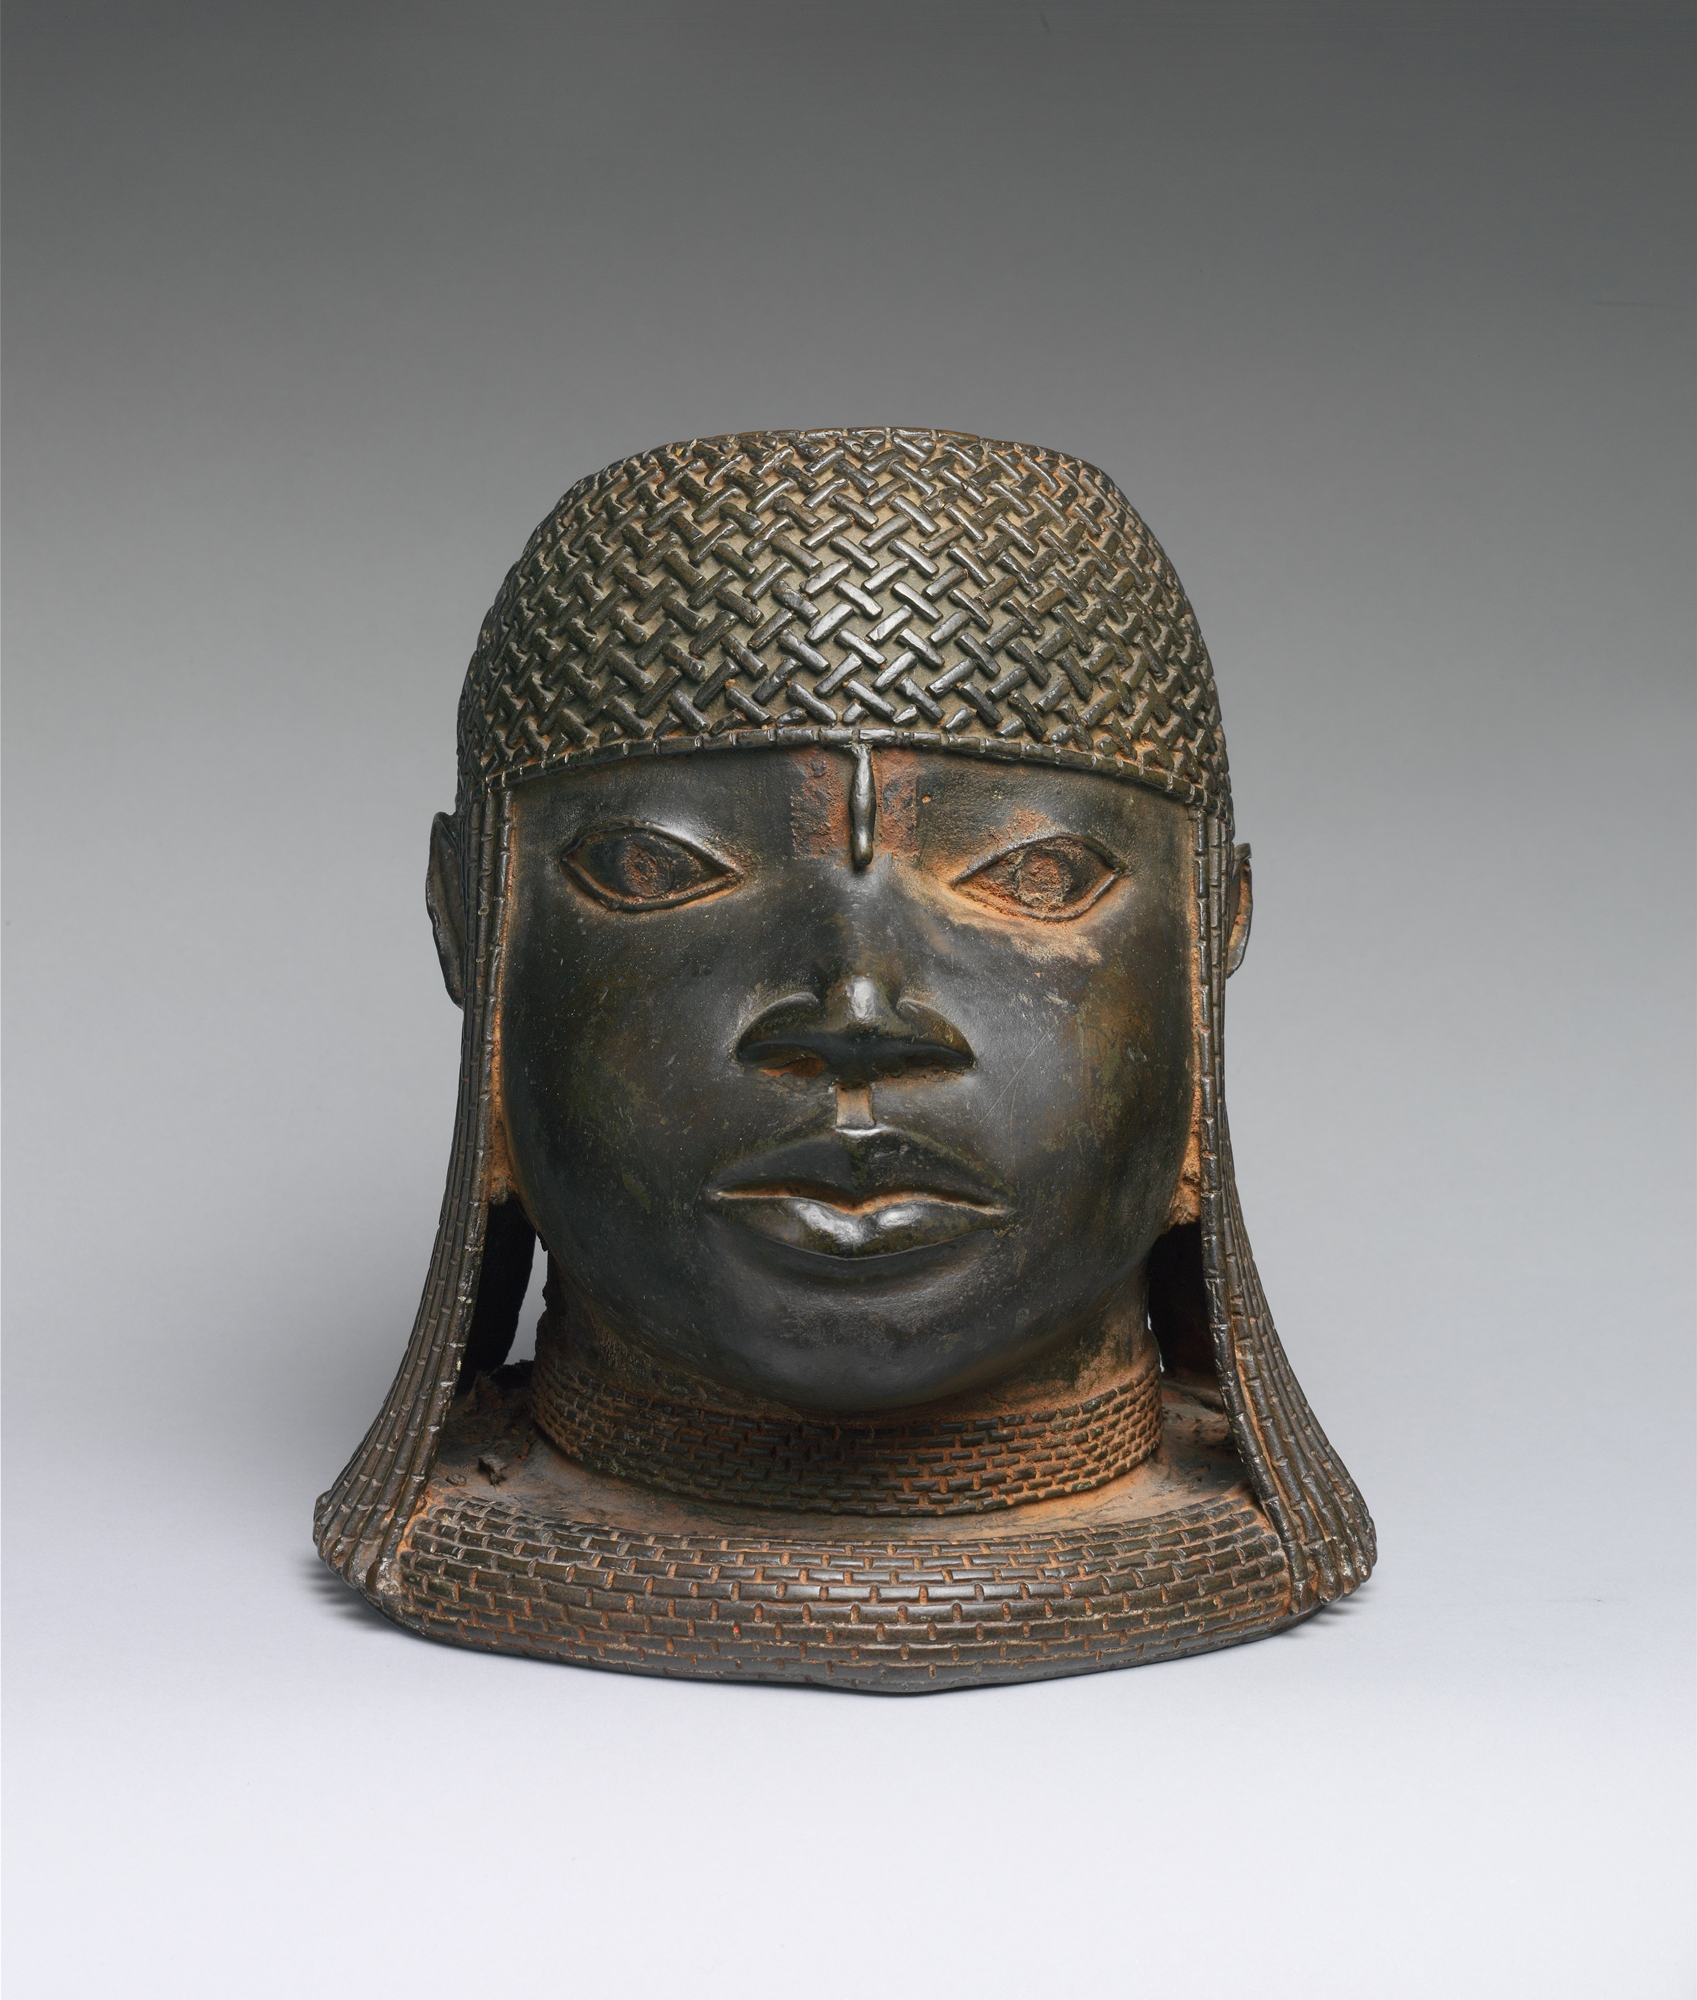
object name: head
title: Ùhúnmwèlaò (head of an ọ́bà)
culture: edo period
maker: ìgùn ẹ́rọ̀nwwọ̀n (brass-casting guild) artists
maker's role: artist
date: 1401-1566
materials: brass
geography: nigeria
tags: kings,heads,men